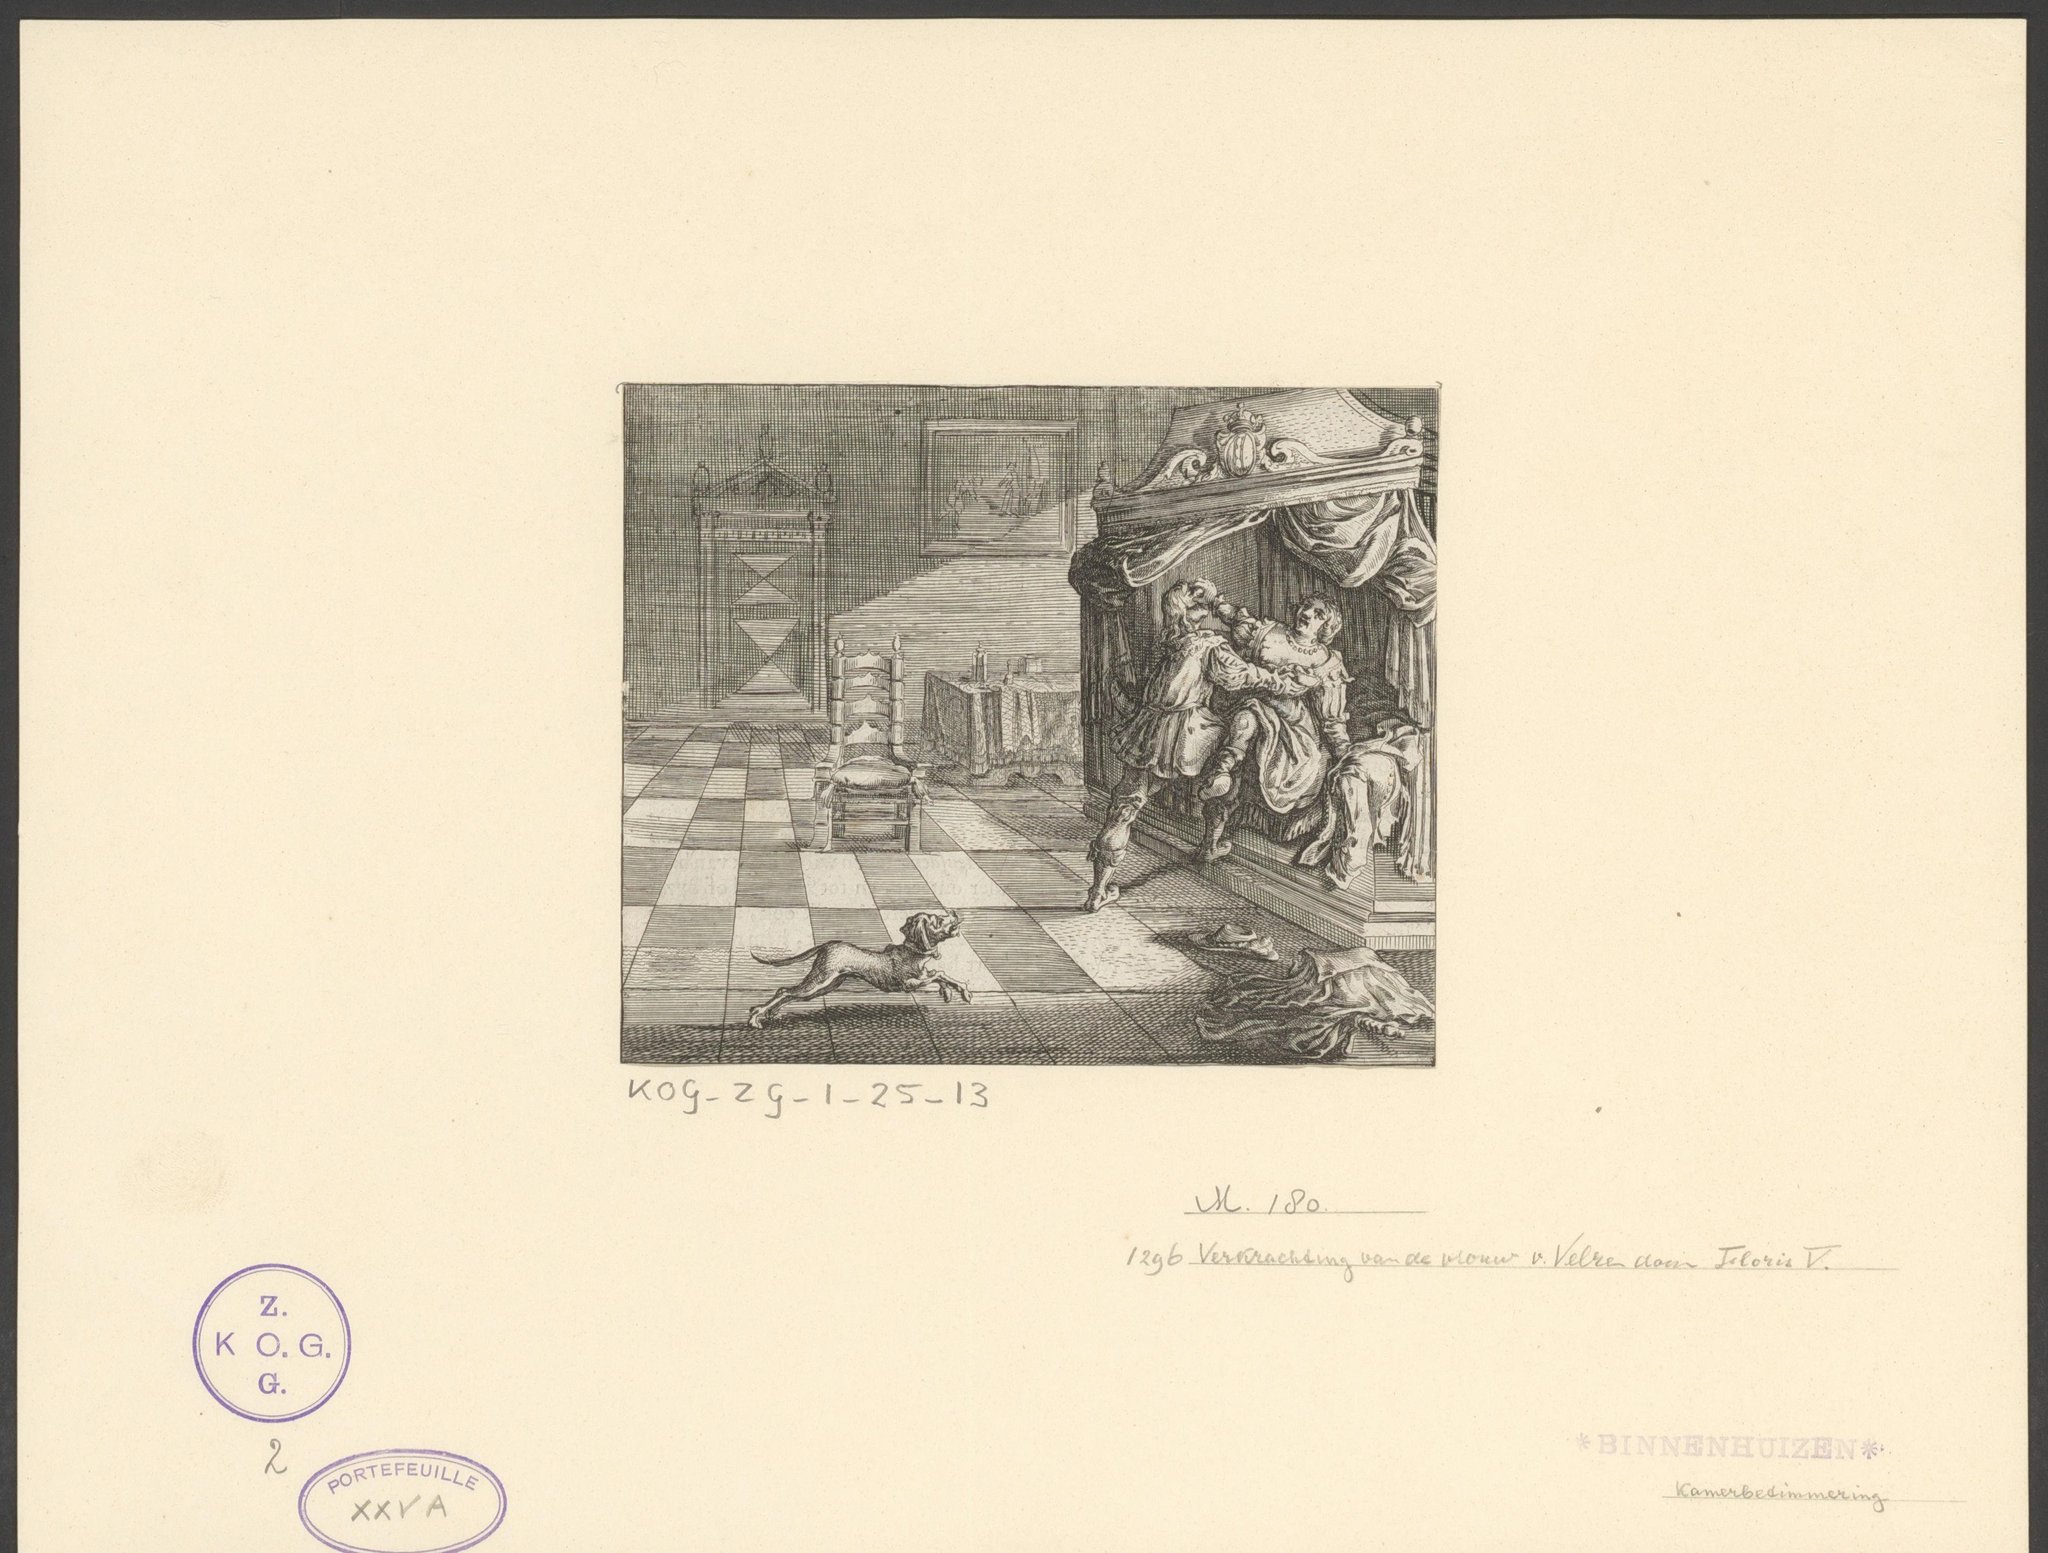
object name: print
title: Verkrachting van de vrouw van Gerard van Velzen door Floris V, 1296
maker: Anonymous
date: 1662-1664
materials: paper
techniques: etching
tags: floris v (graaf van holland en zeeland), rape, violation, netherlands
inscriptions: stamp, stamp, collector's mark: Lugt 1641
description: Verkrachting van de vrouw van Gerard van Velzen door Floris V. Floris overmeestert de vrouw in een slaapkamer, 1296. Onderwerpsrubrieken binnen de Atlas Zeden en Gewoonten: Zeden en Gewoonten in Engeren Zin, De Woning, Binnenhuizen, Kamerbetimmering.